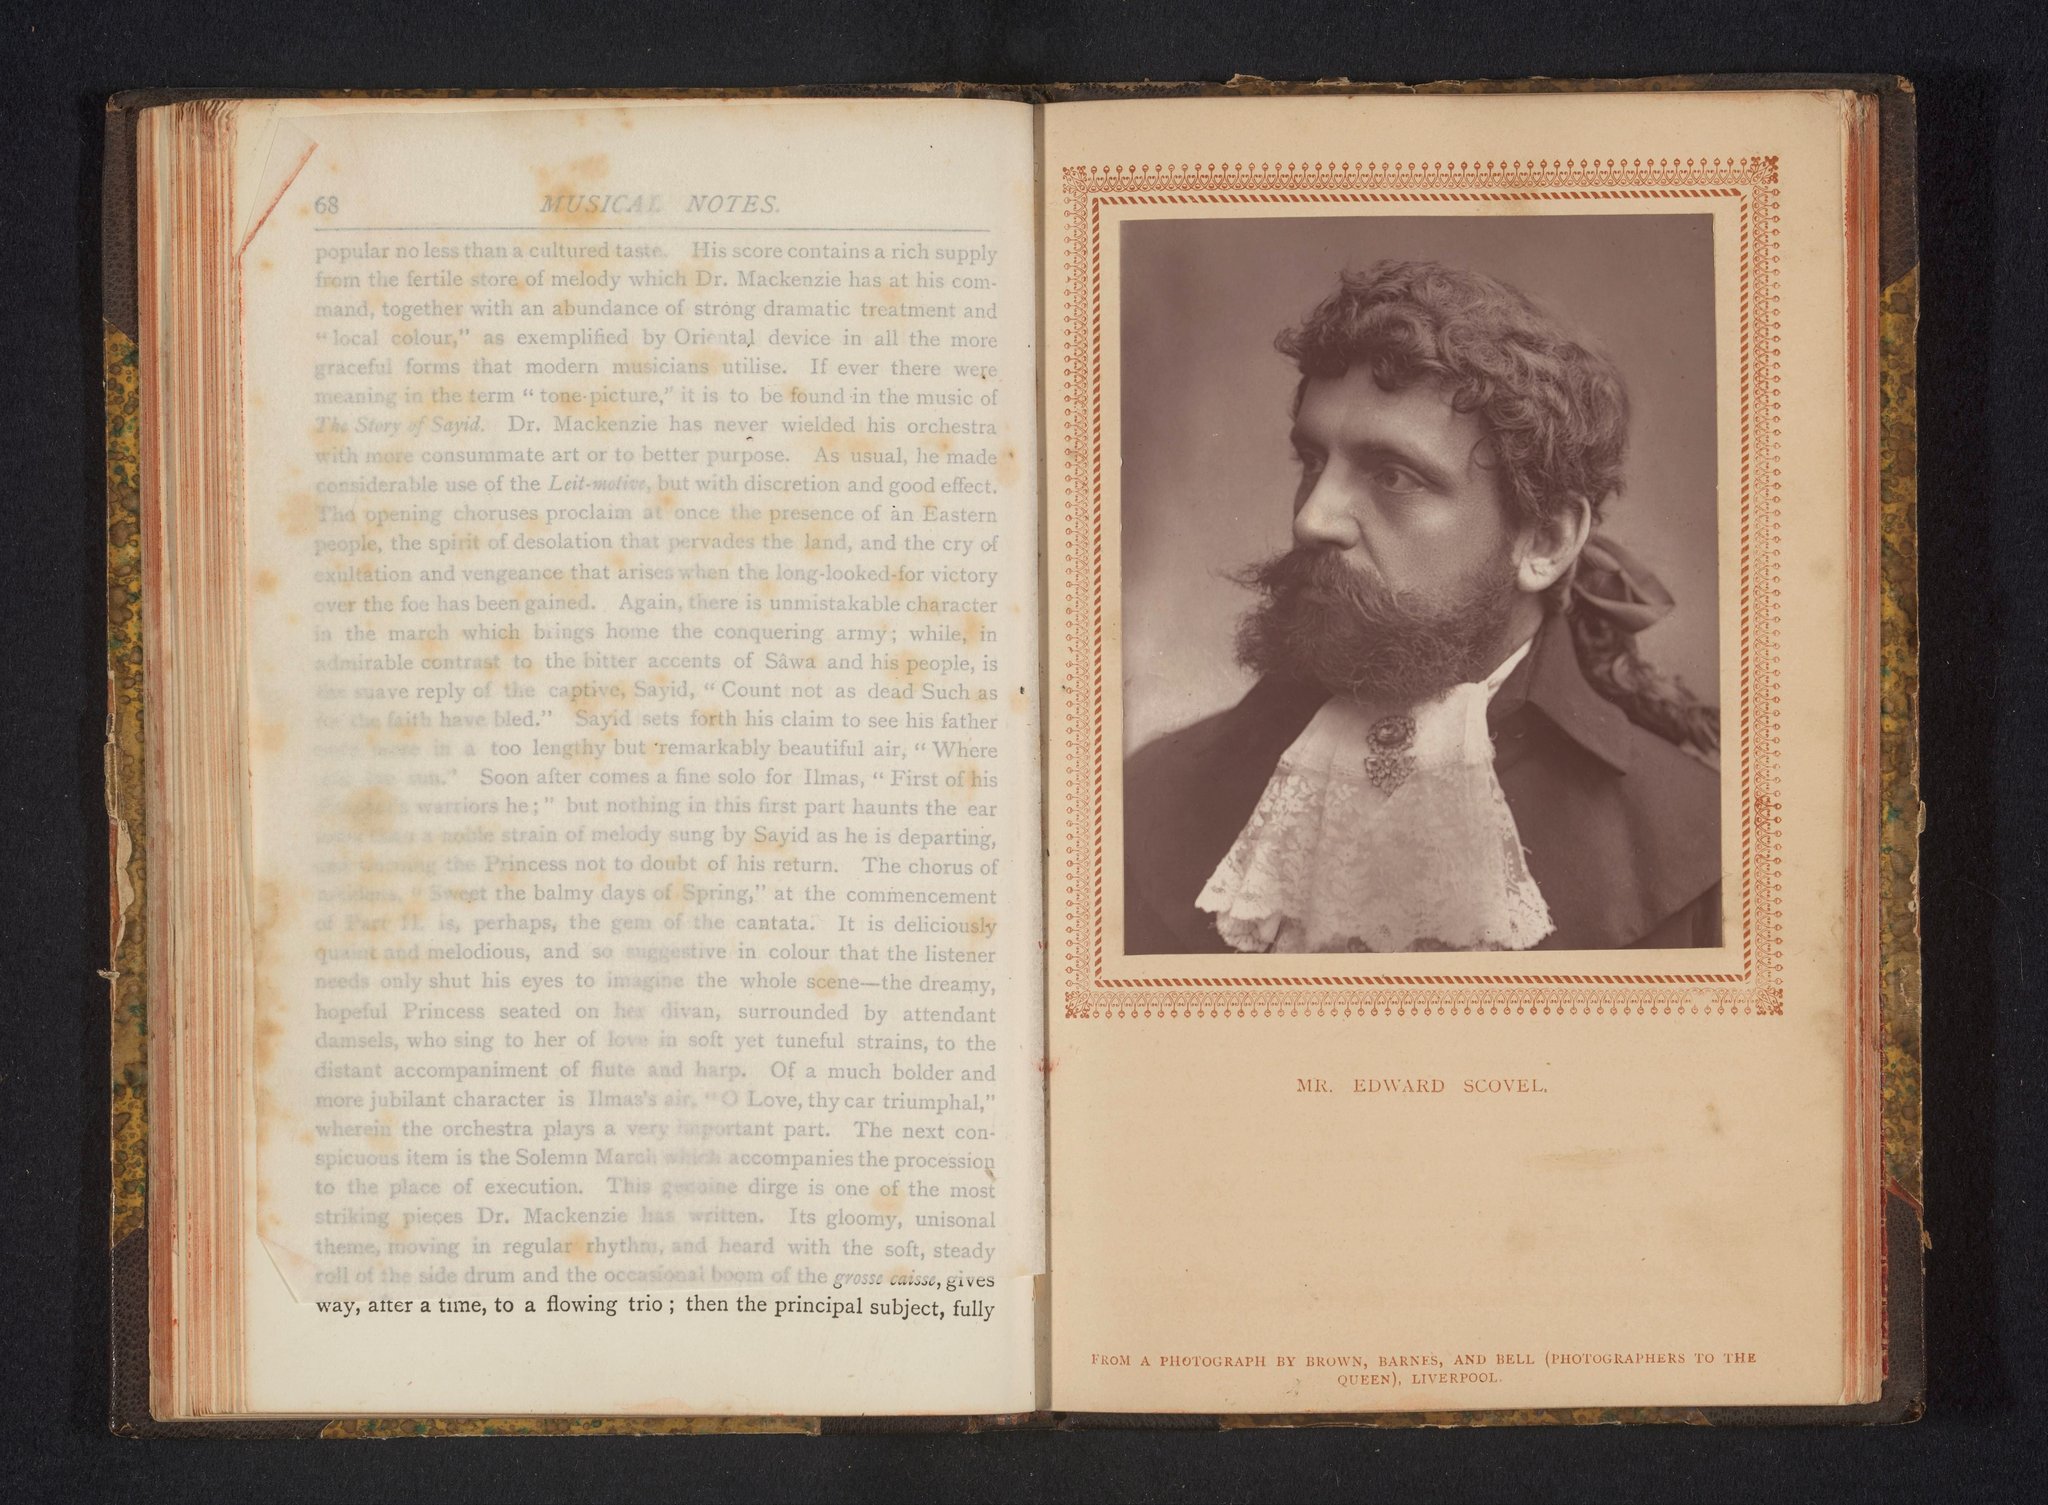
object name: page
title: Mr Edward Scovel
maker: Anonymous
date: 1885-1887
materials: paper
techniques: woodburytype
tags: adult man, historical persons